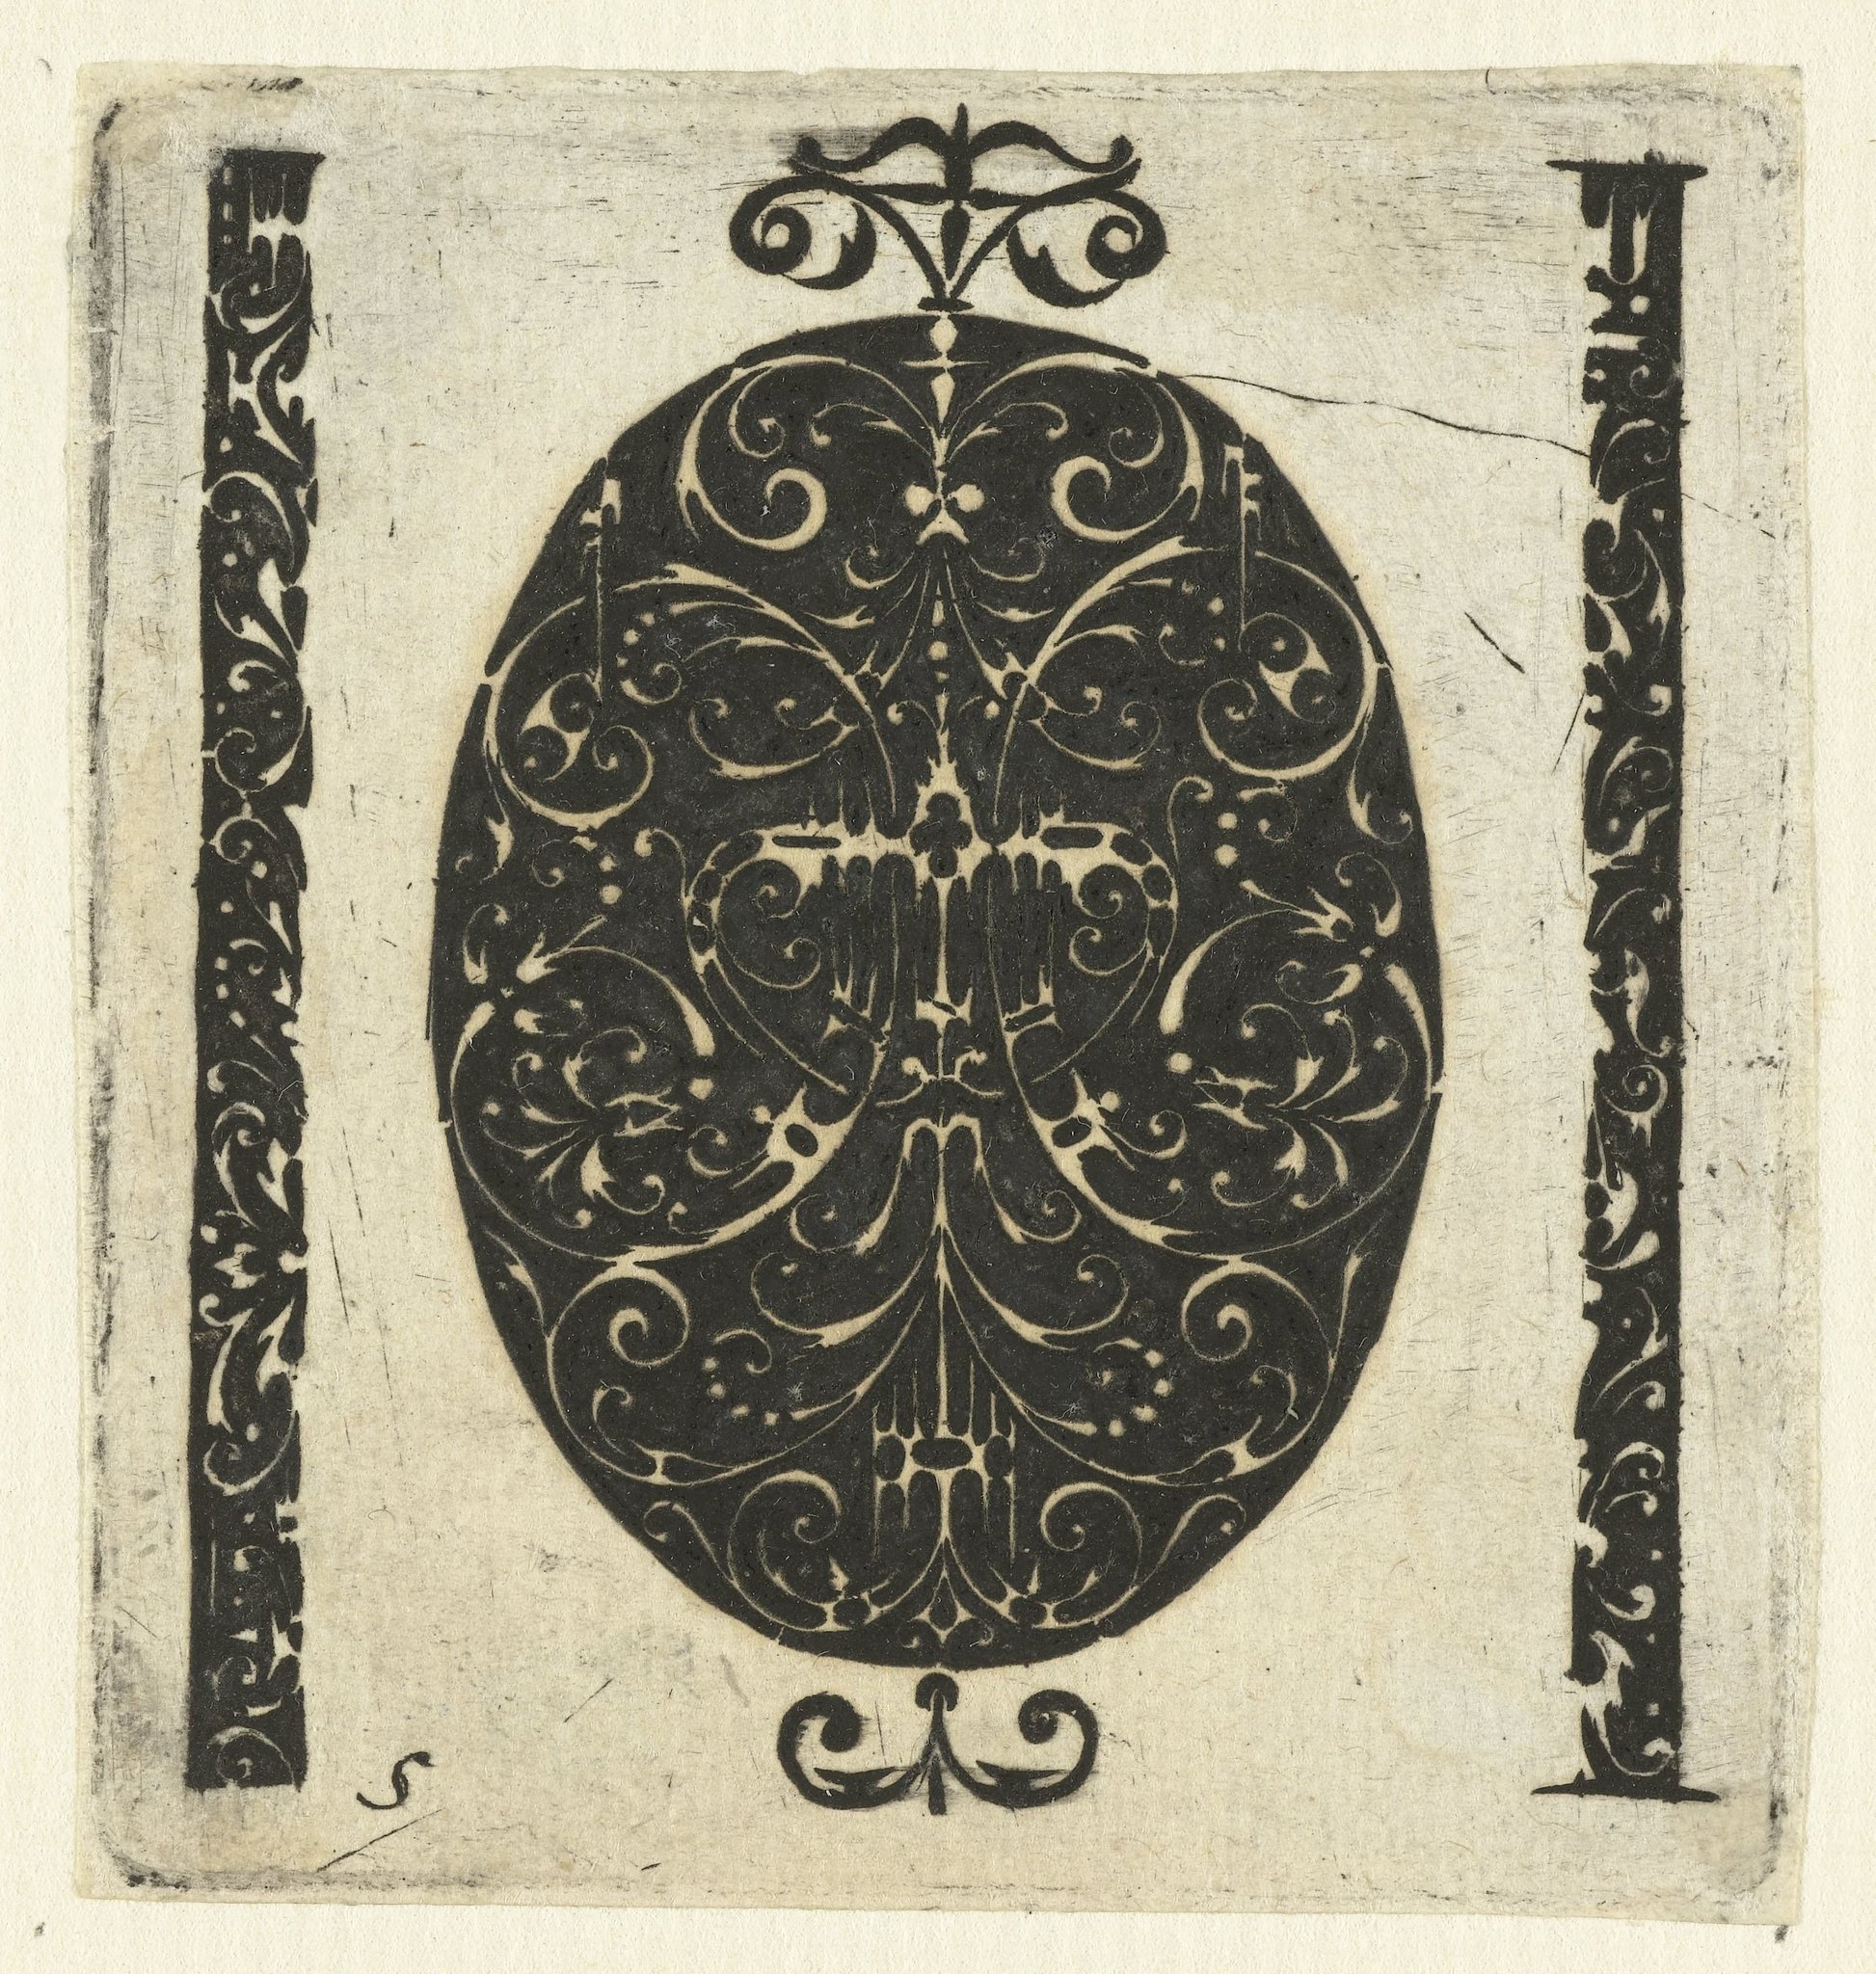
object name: print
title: Ontwerpen voor sieraden in de vorm van zwartornamenten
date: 1612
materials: paper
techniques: engraving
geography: leiden